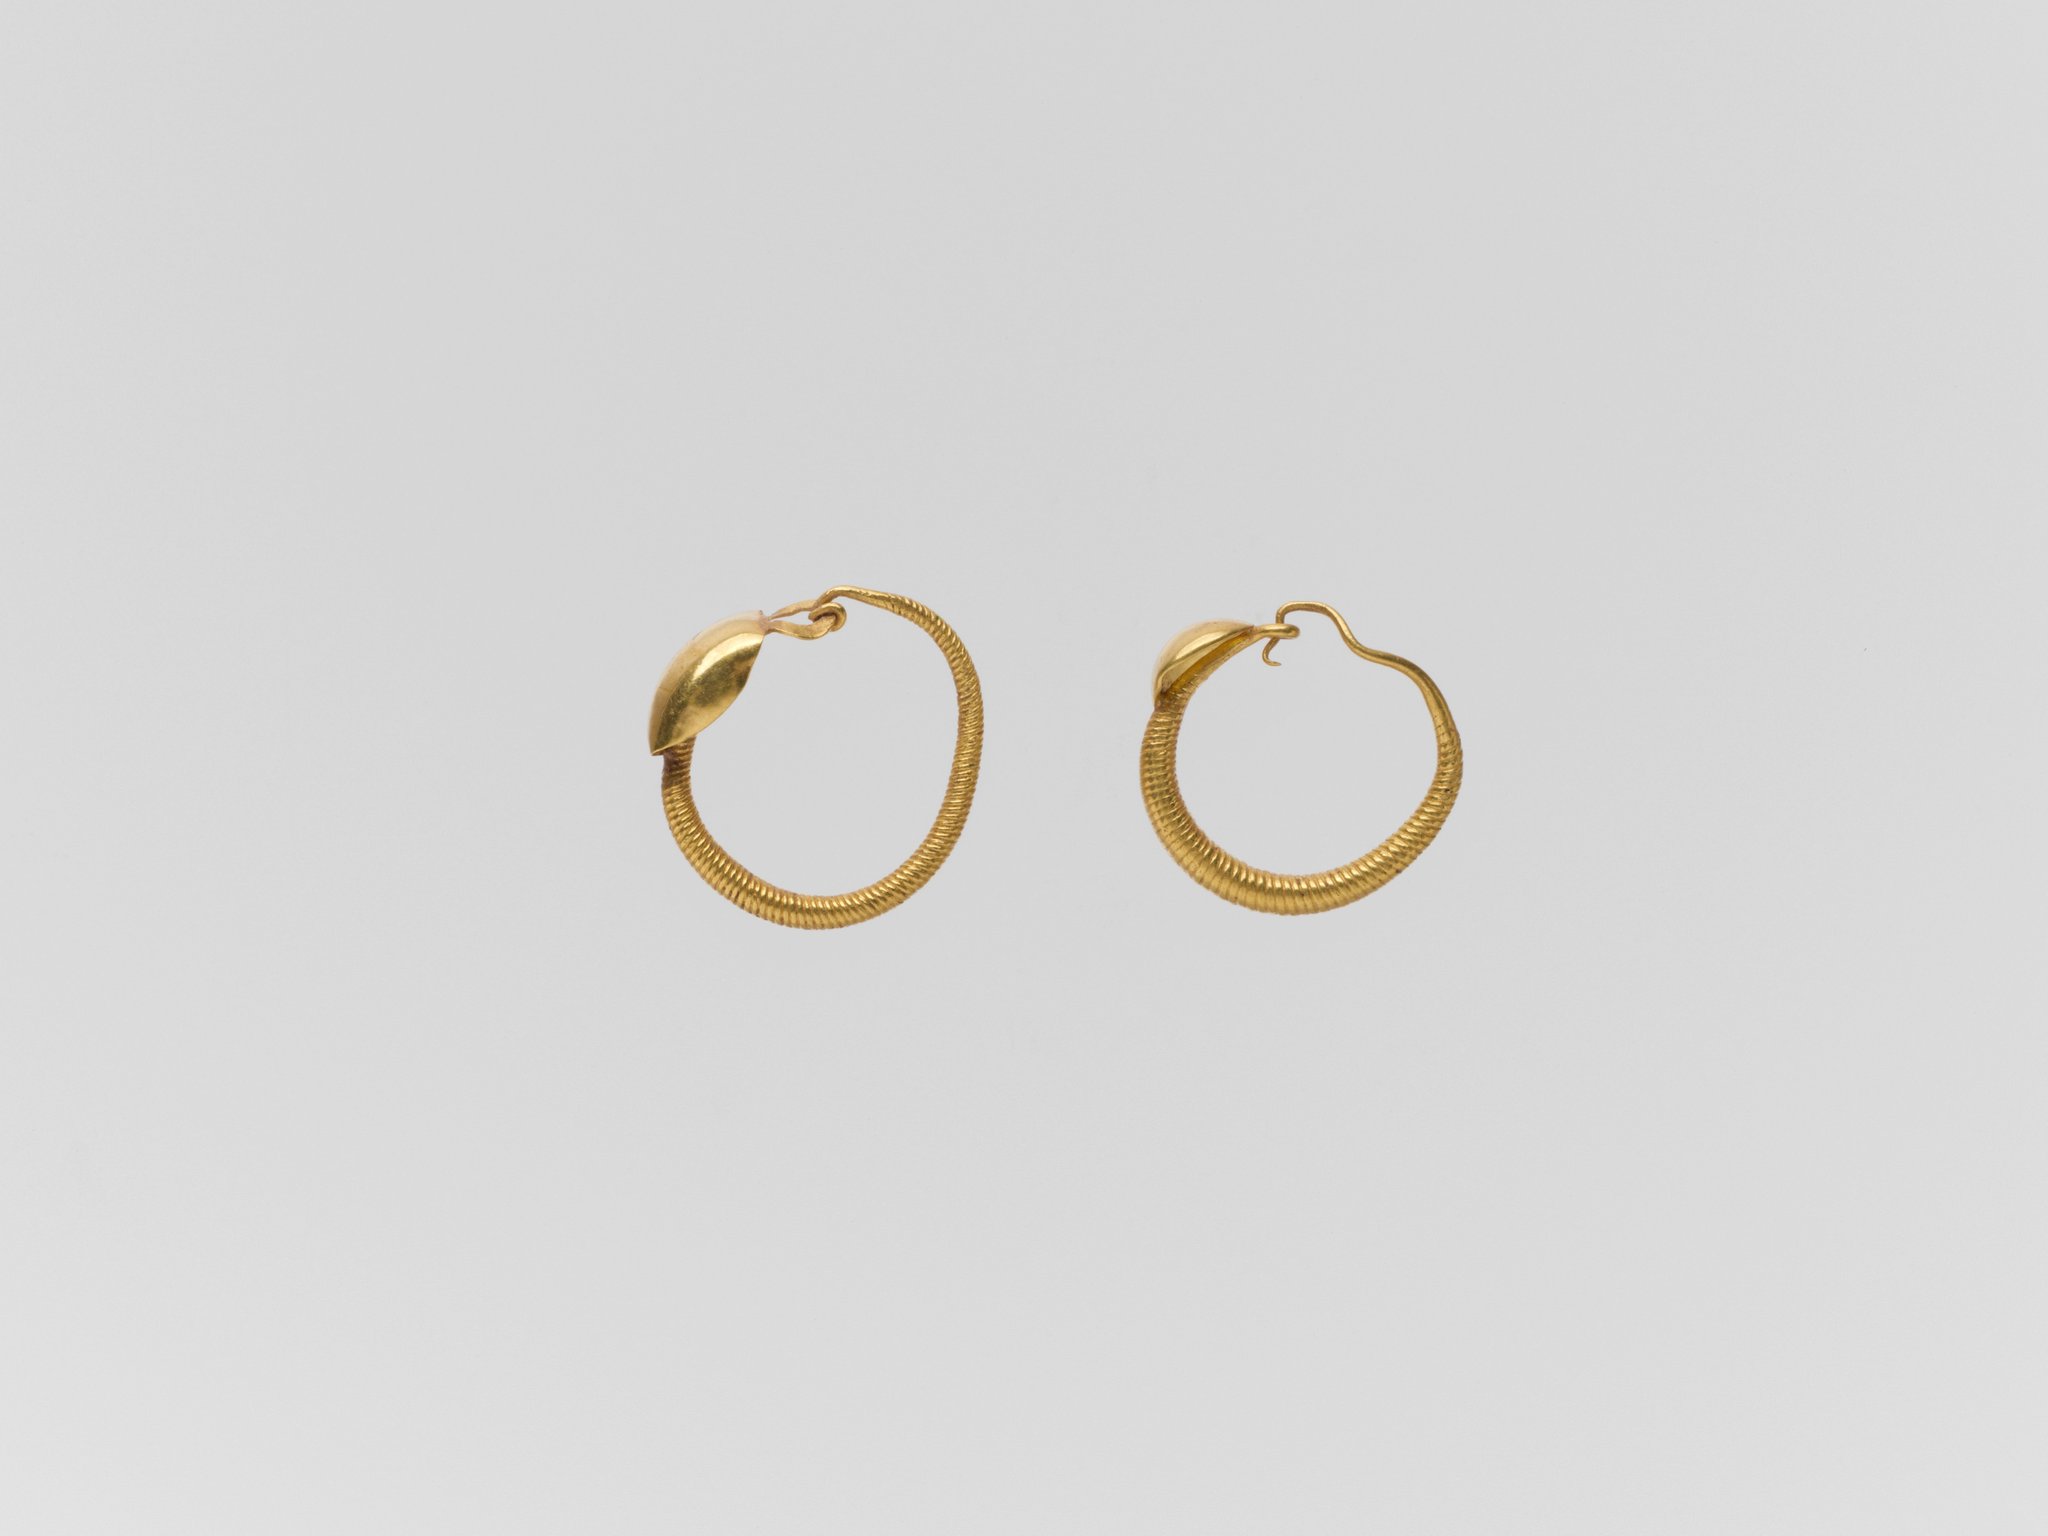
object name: earring with plain loop and disc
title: Gold earring with convex disc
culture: roman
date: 101-300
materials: gold